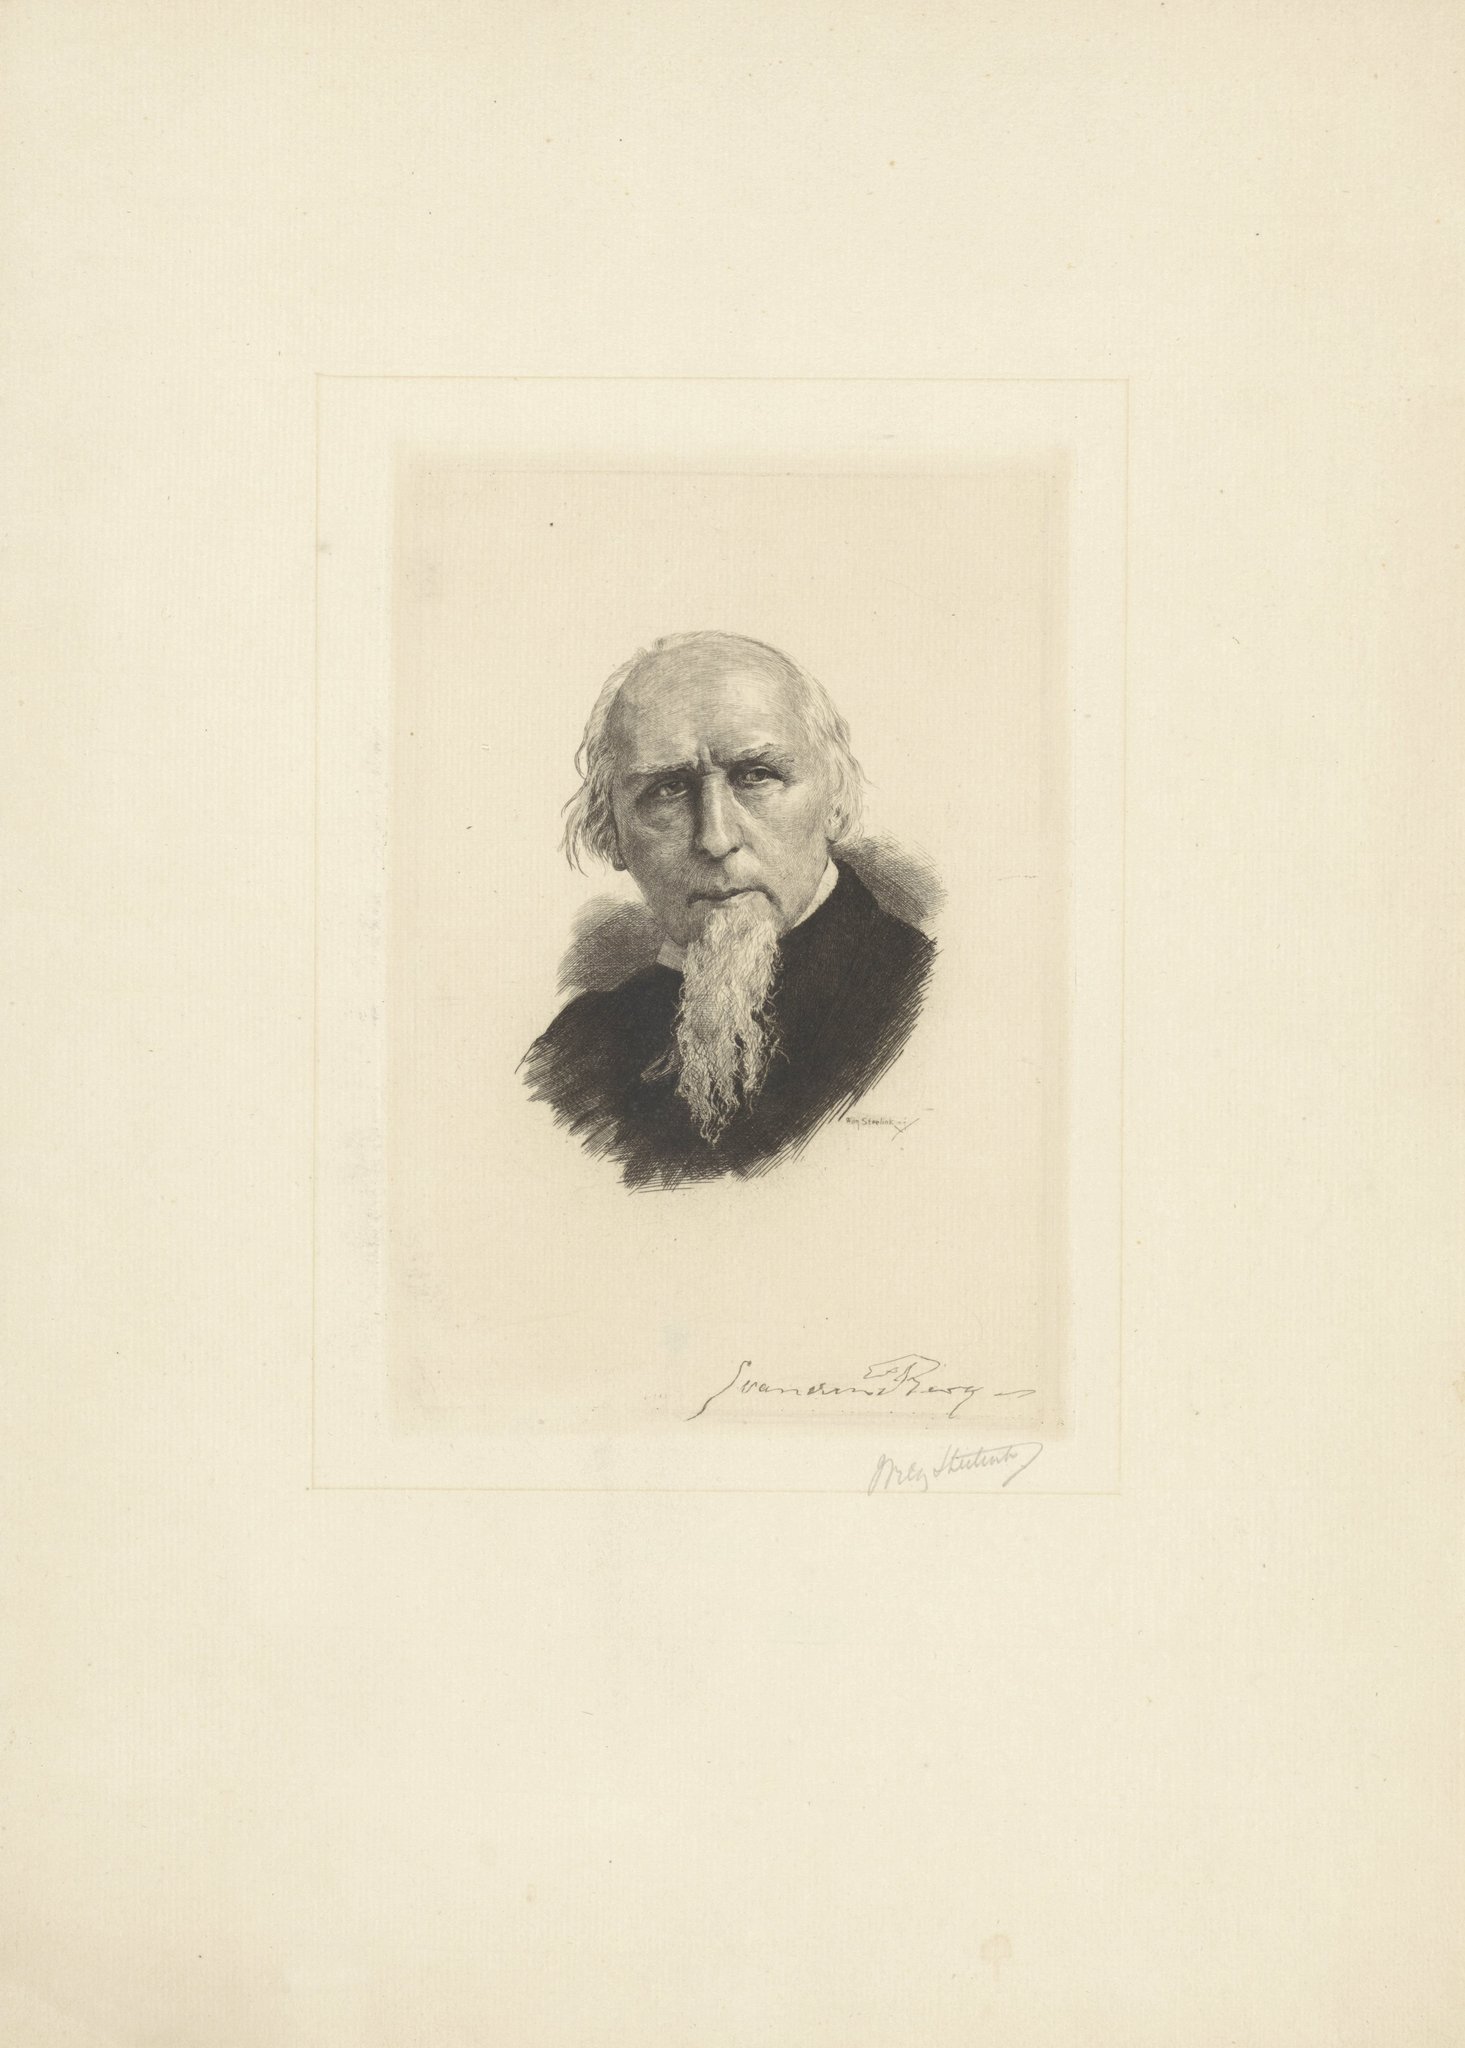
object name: print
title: Portret van Simon van den Berg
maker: willem steelink (ii)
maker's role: draughtsman, print maker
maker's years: 1856-1928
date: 1866-1928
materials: paper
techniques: etching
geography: netherlands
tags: print maker, simon van den berg, portrait, self-portrait of painter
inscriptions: collector's mark: Lugt 2228, collector's mark: Lugt 2760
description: Portret van de kunstenaar Simon van den Berg. Rechtsonder zijn handtekening.